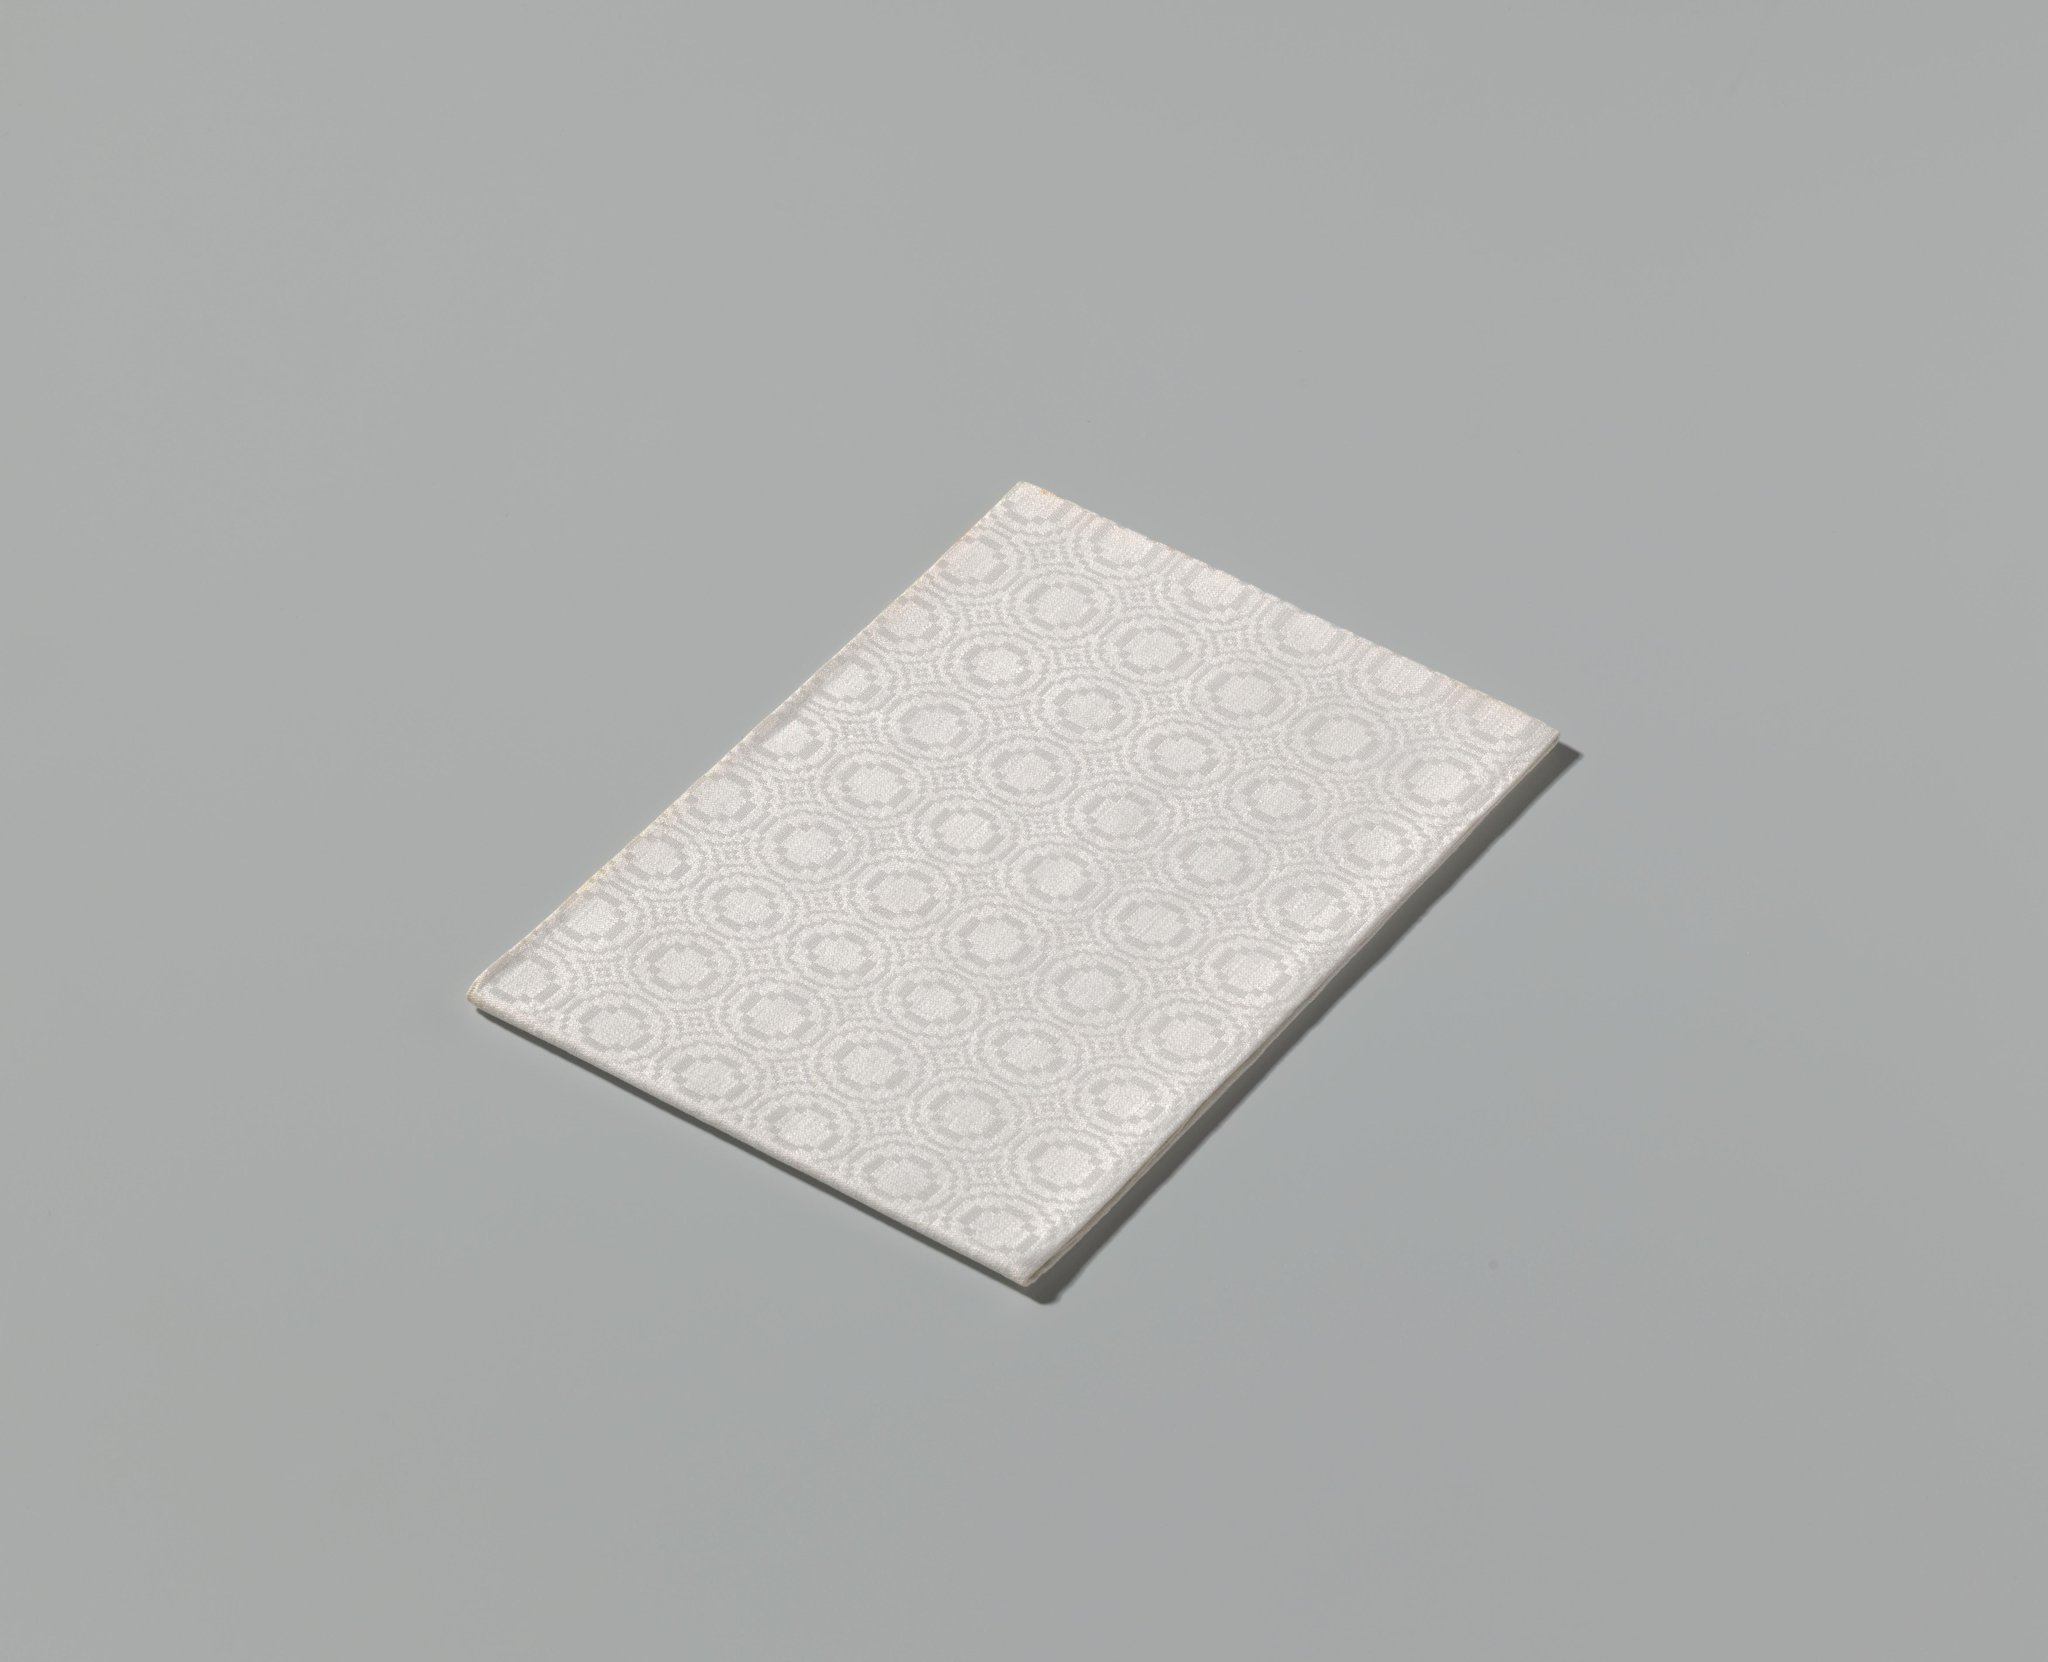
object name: napkin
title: Servet van linnen met pellenpatroon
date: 1600-1650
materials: linen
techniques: peeled fabric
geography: northern netherlands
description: wit linnen servet met pellen patroon, merk IVG